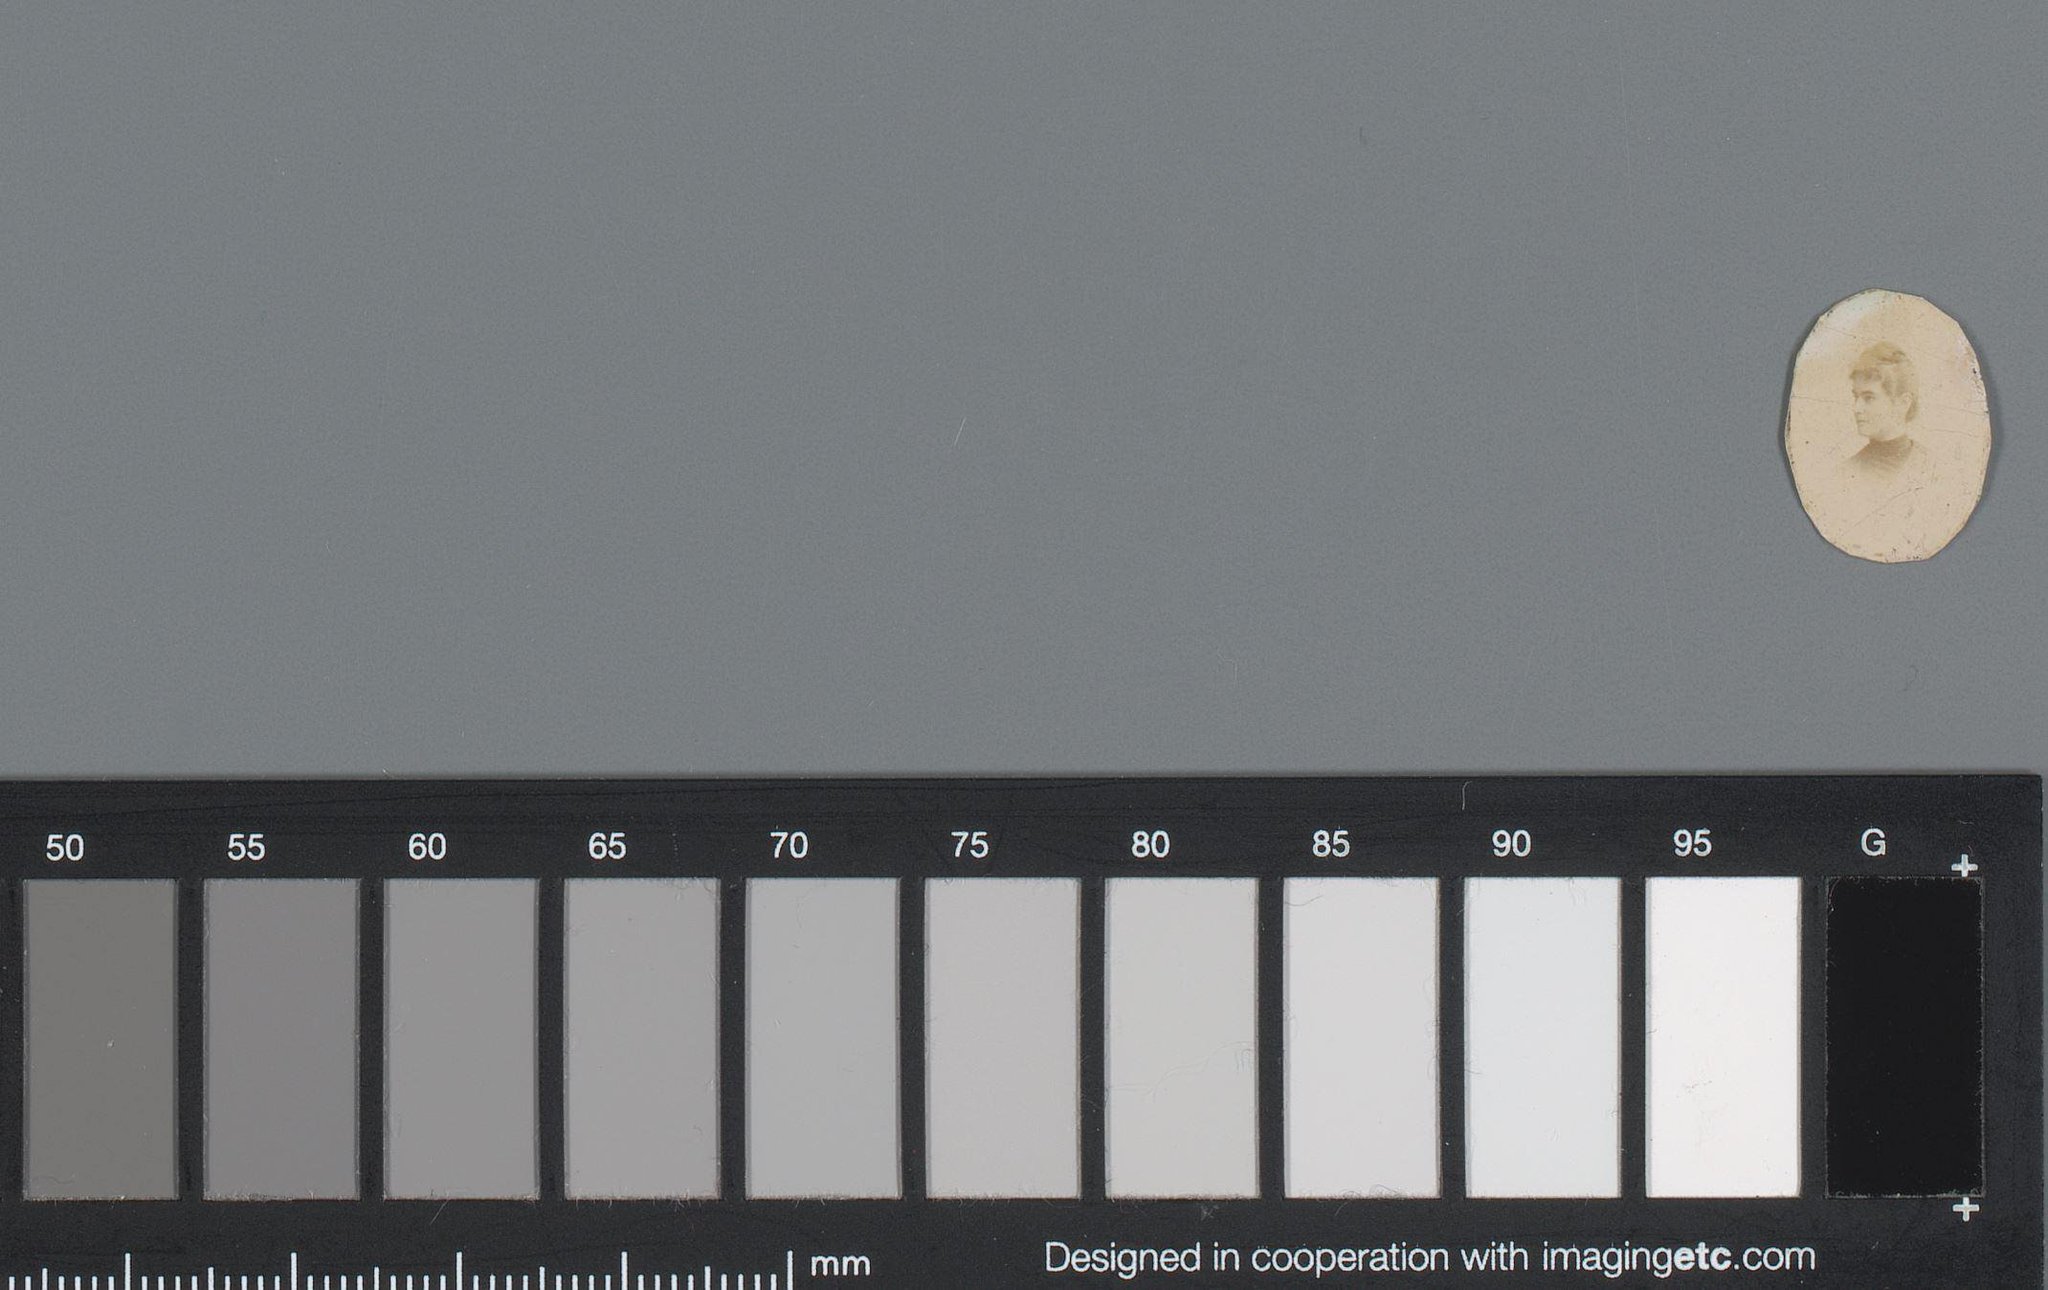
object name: photograph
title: Miniatuurportret van een onbekende vrouw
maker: Anonymous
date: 1890-1910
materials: paper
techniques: gelatin silver print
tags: adult woman